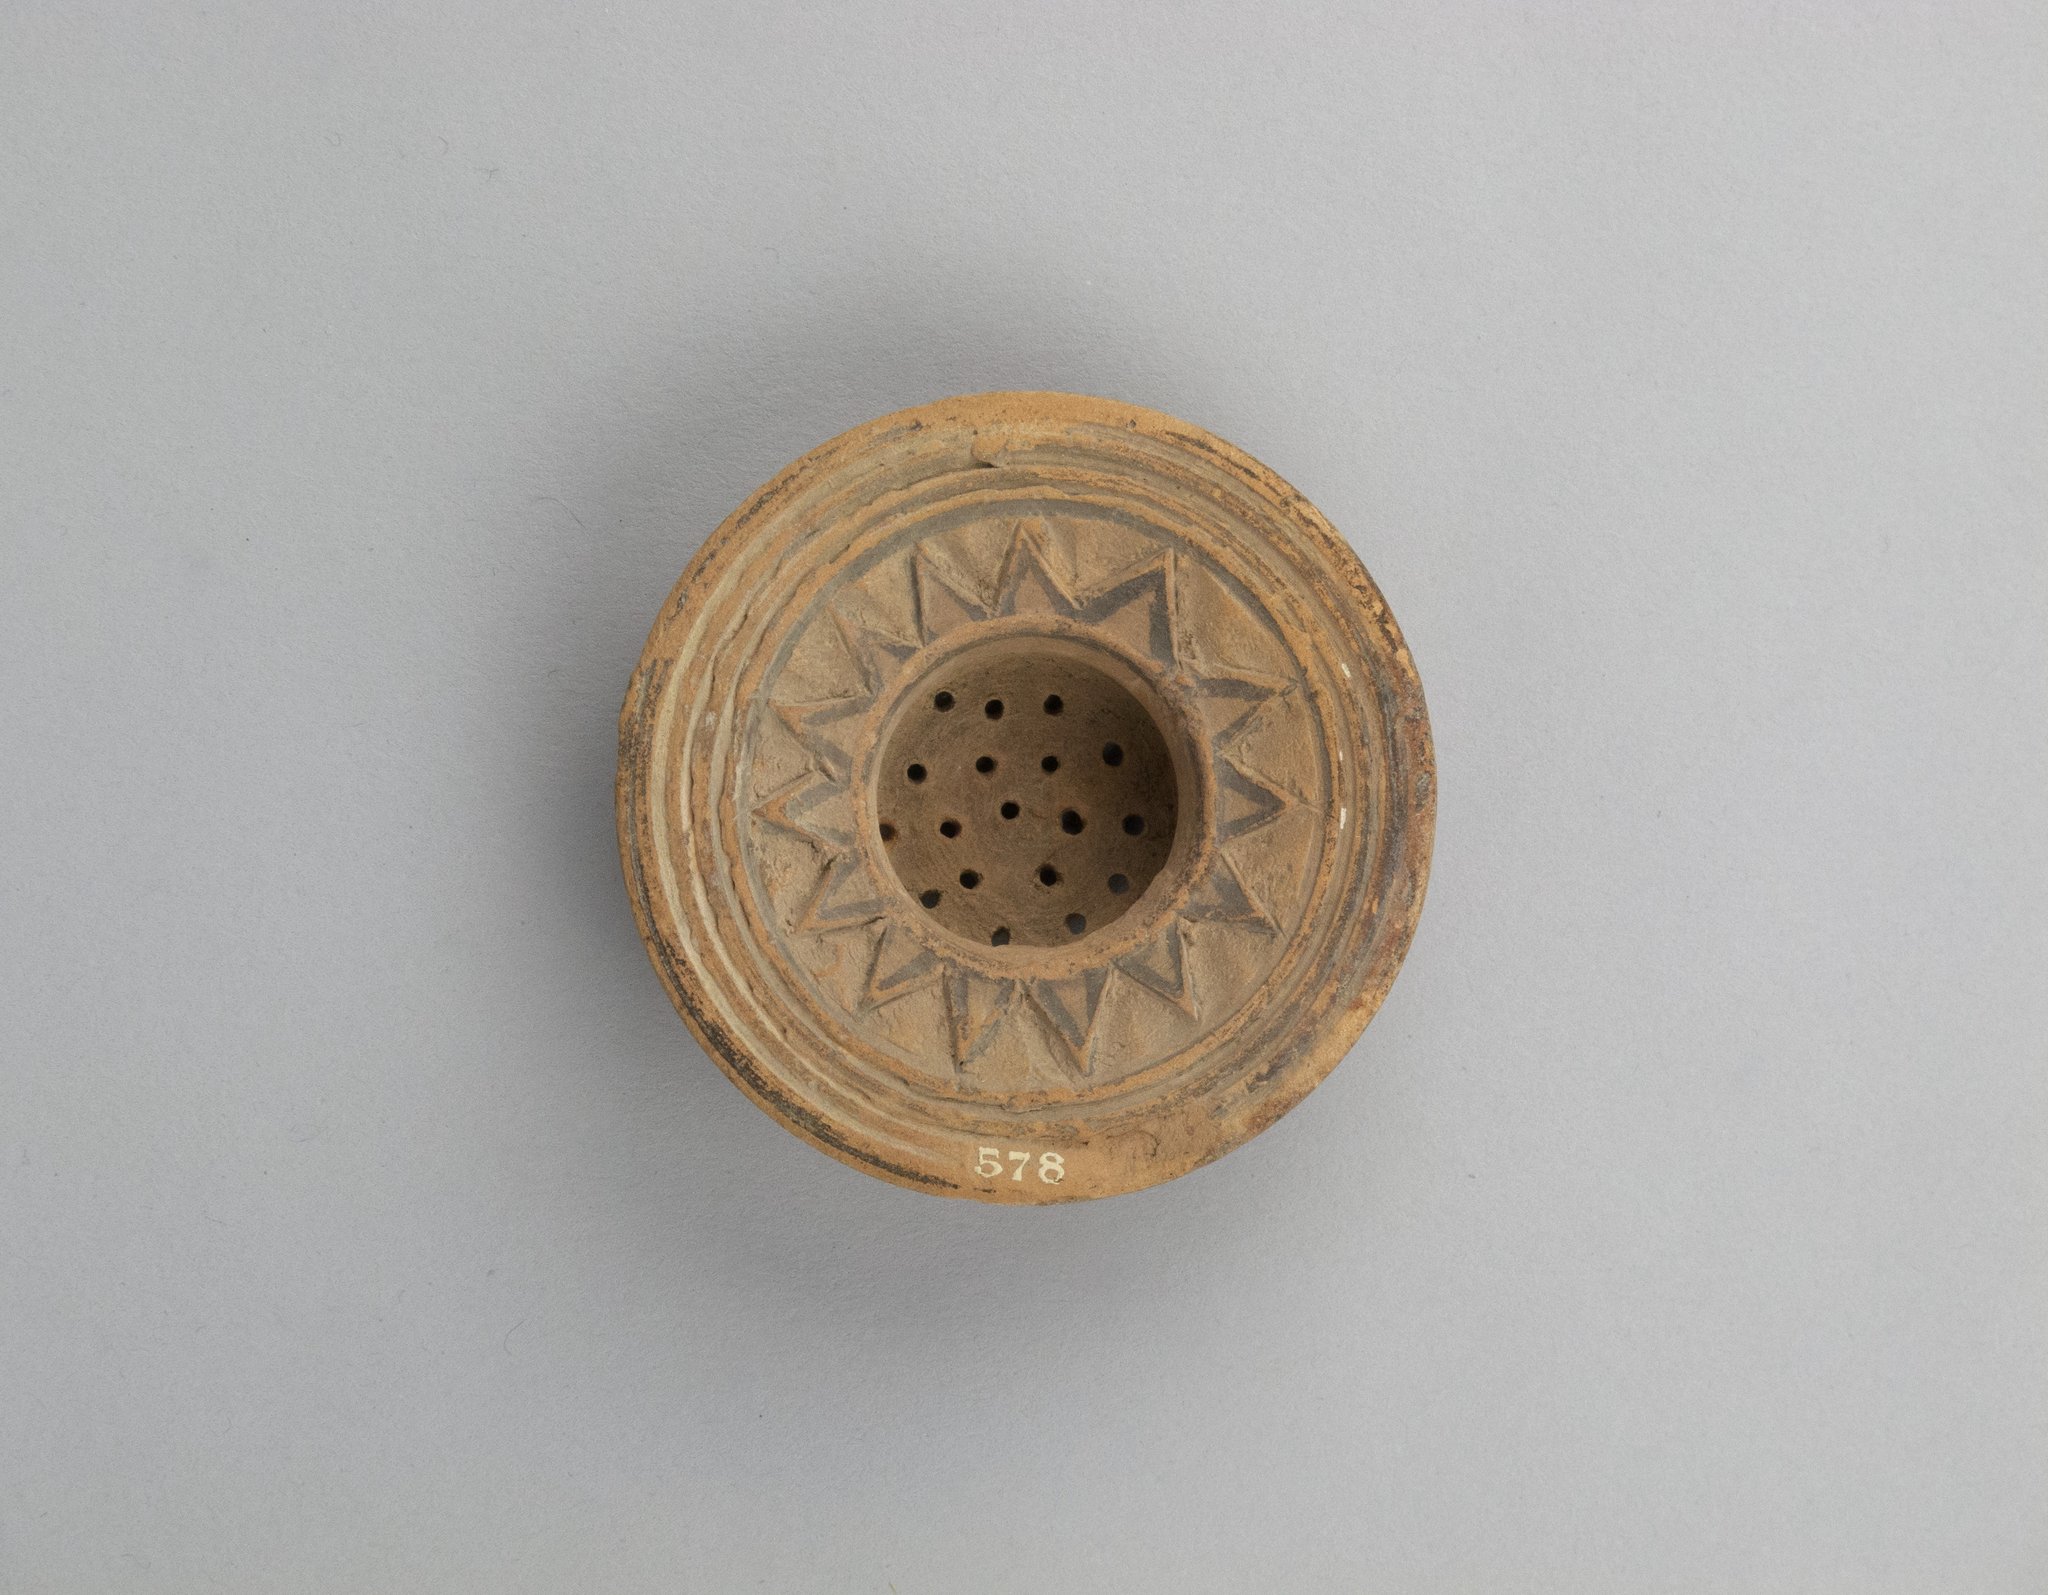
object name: strainer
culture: cypriot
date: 750-480 BCE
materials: terracotta